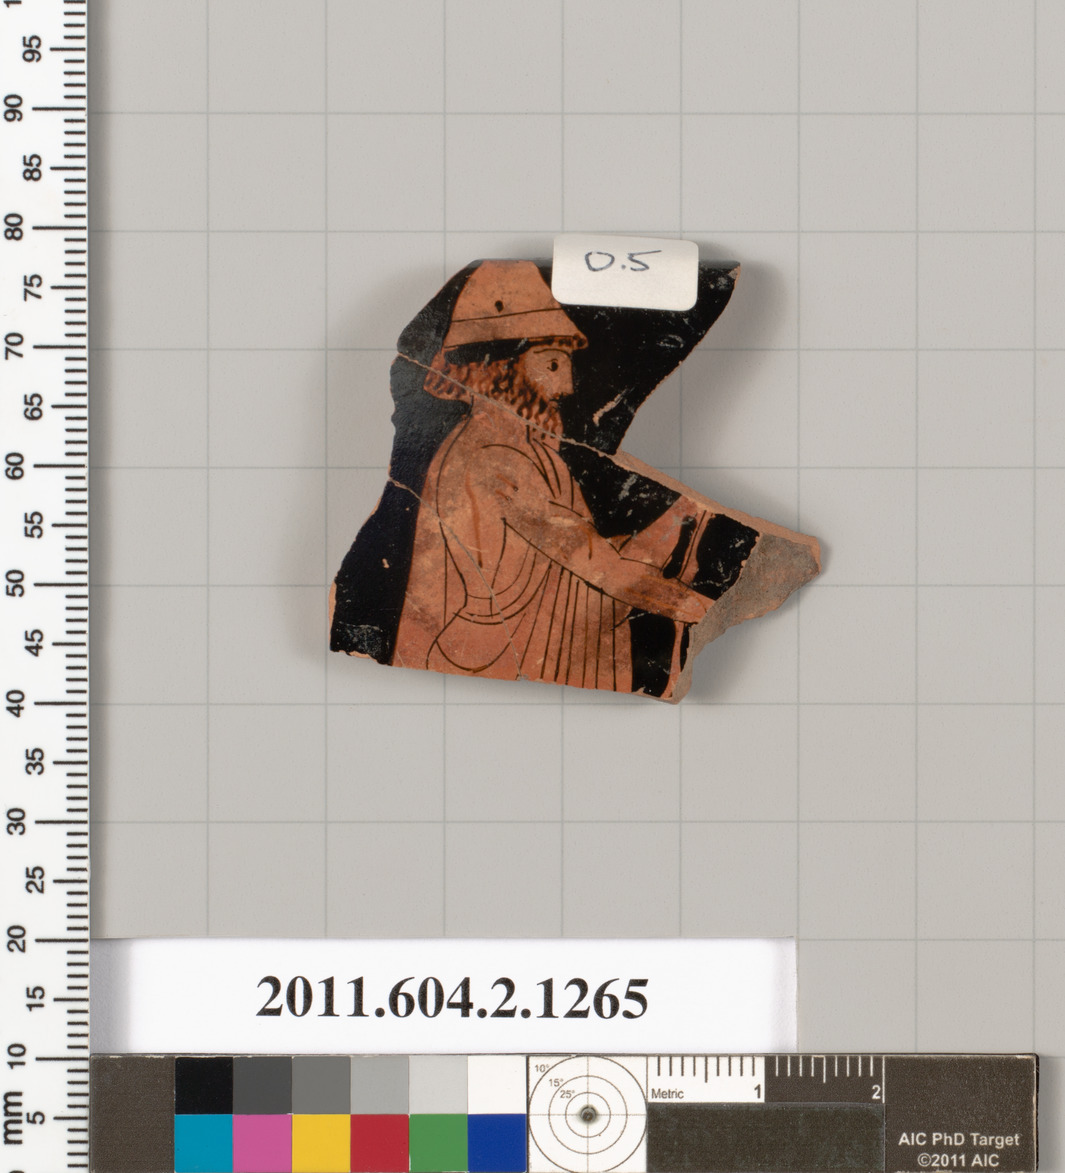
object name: skyphos fragment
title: Terracotta rim fragment of a skyphos (deep drinking cup)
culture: greek, attic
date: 475-451 BCE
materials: terracotta